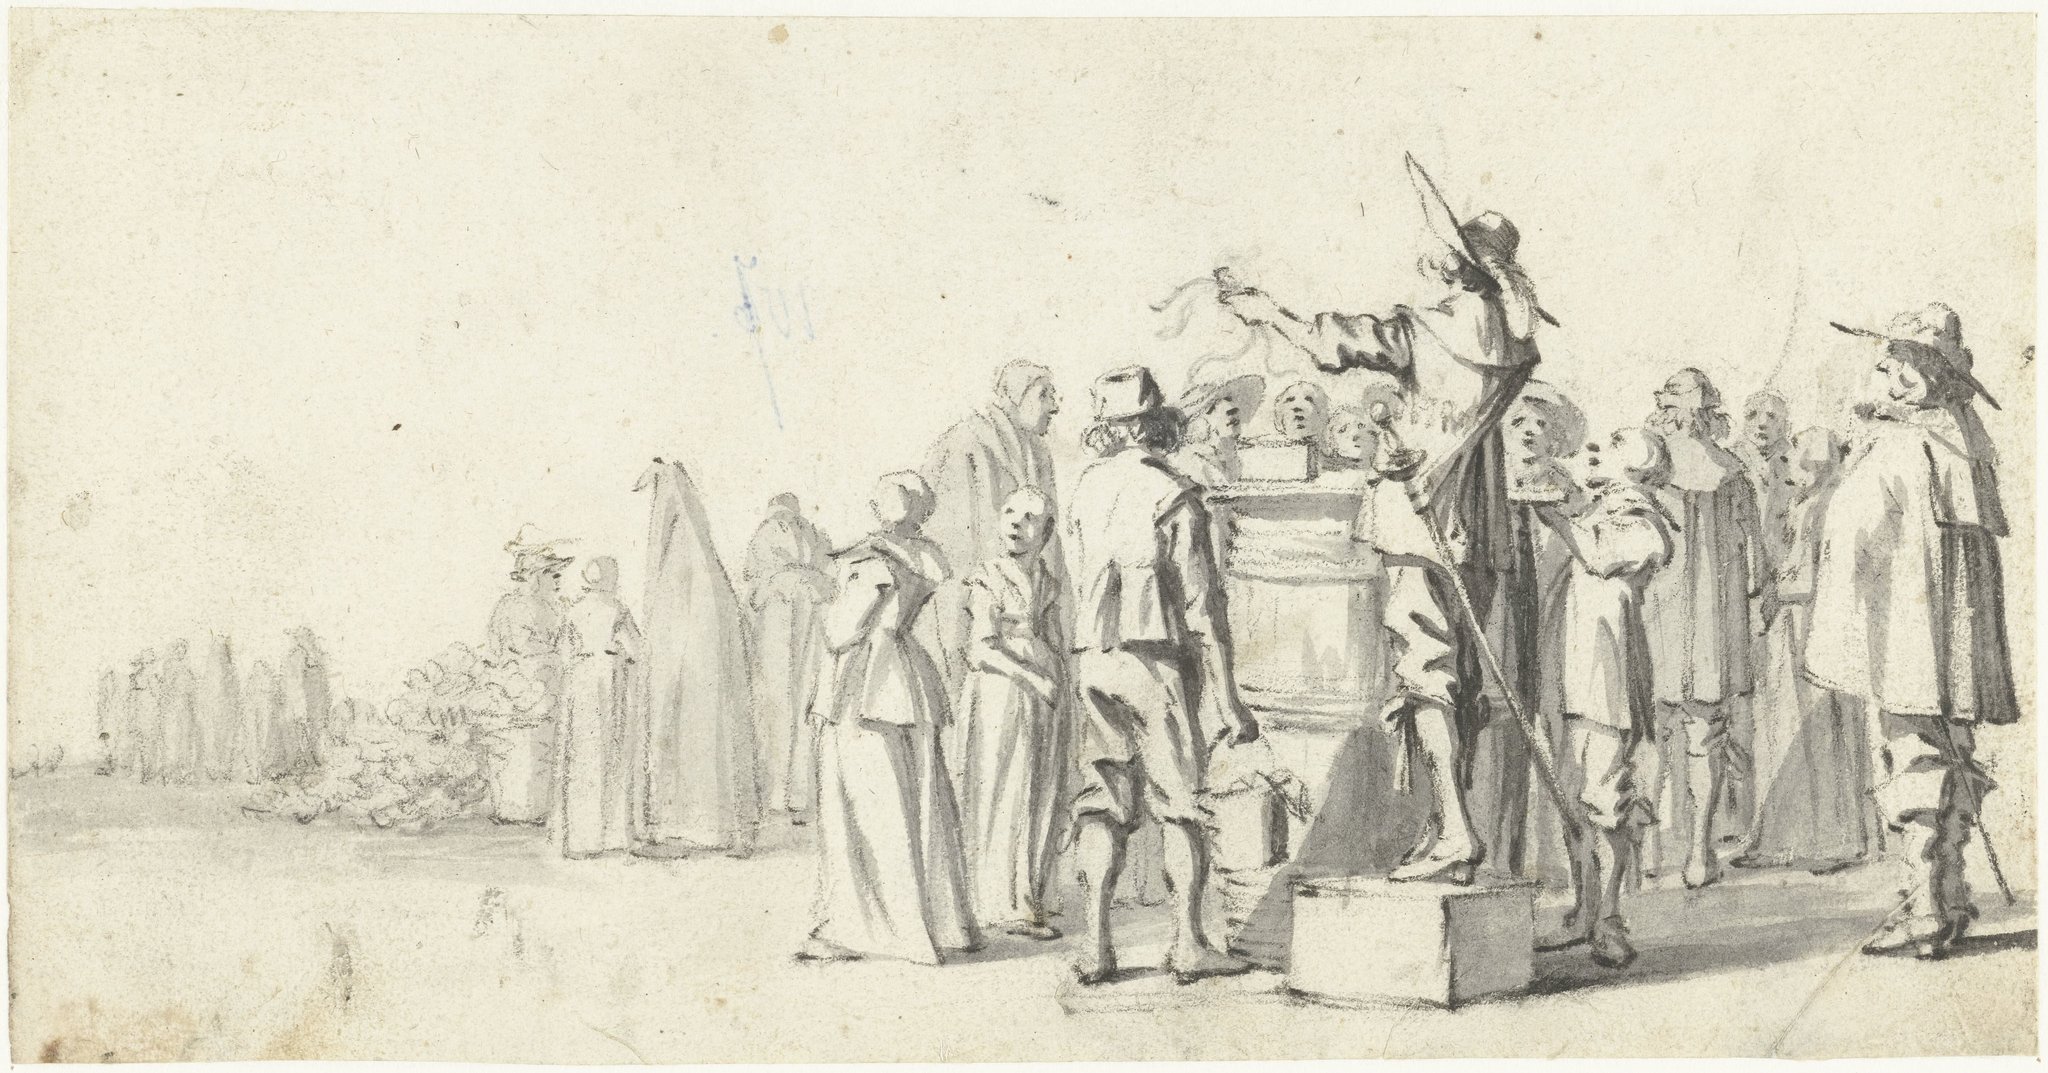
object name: drawing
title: Omroeper op een marktplein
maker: gerard ter borch (ii)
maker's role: draughtsman, painter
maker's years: 1617-1681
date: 1630-1635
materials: chalk, ink, paper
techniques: brush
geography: haarlem